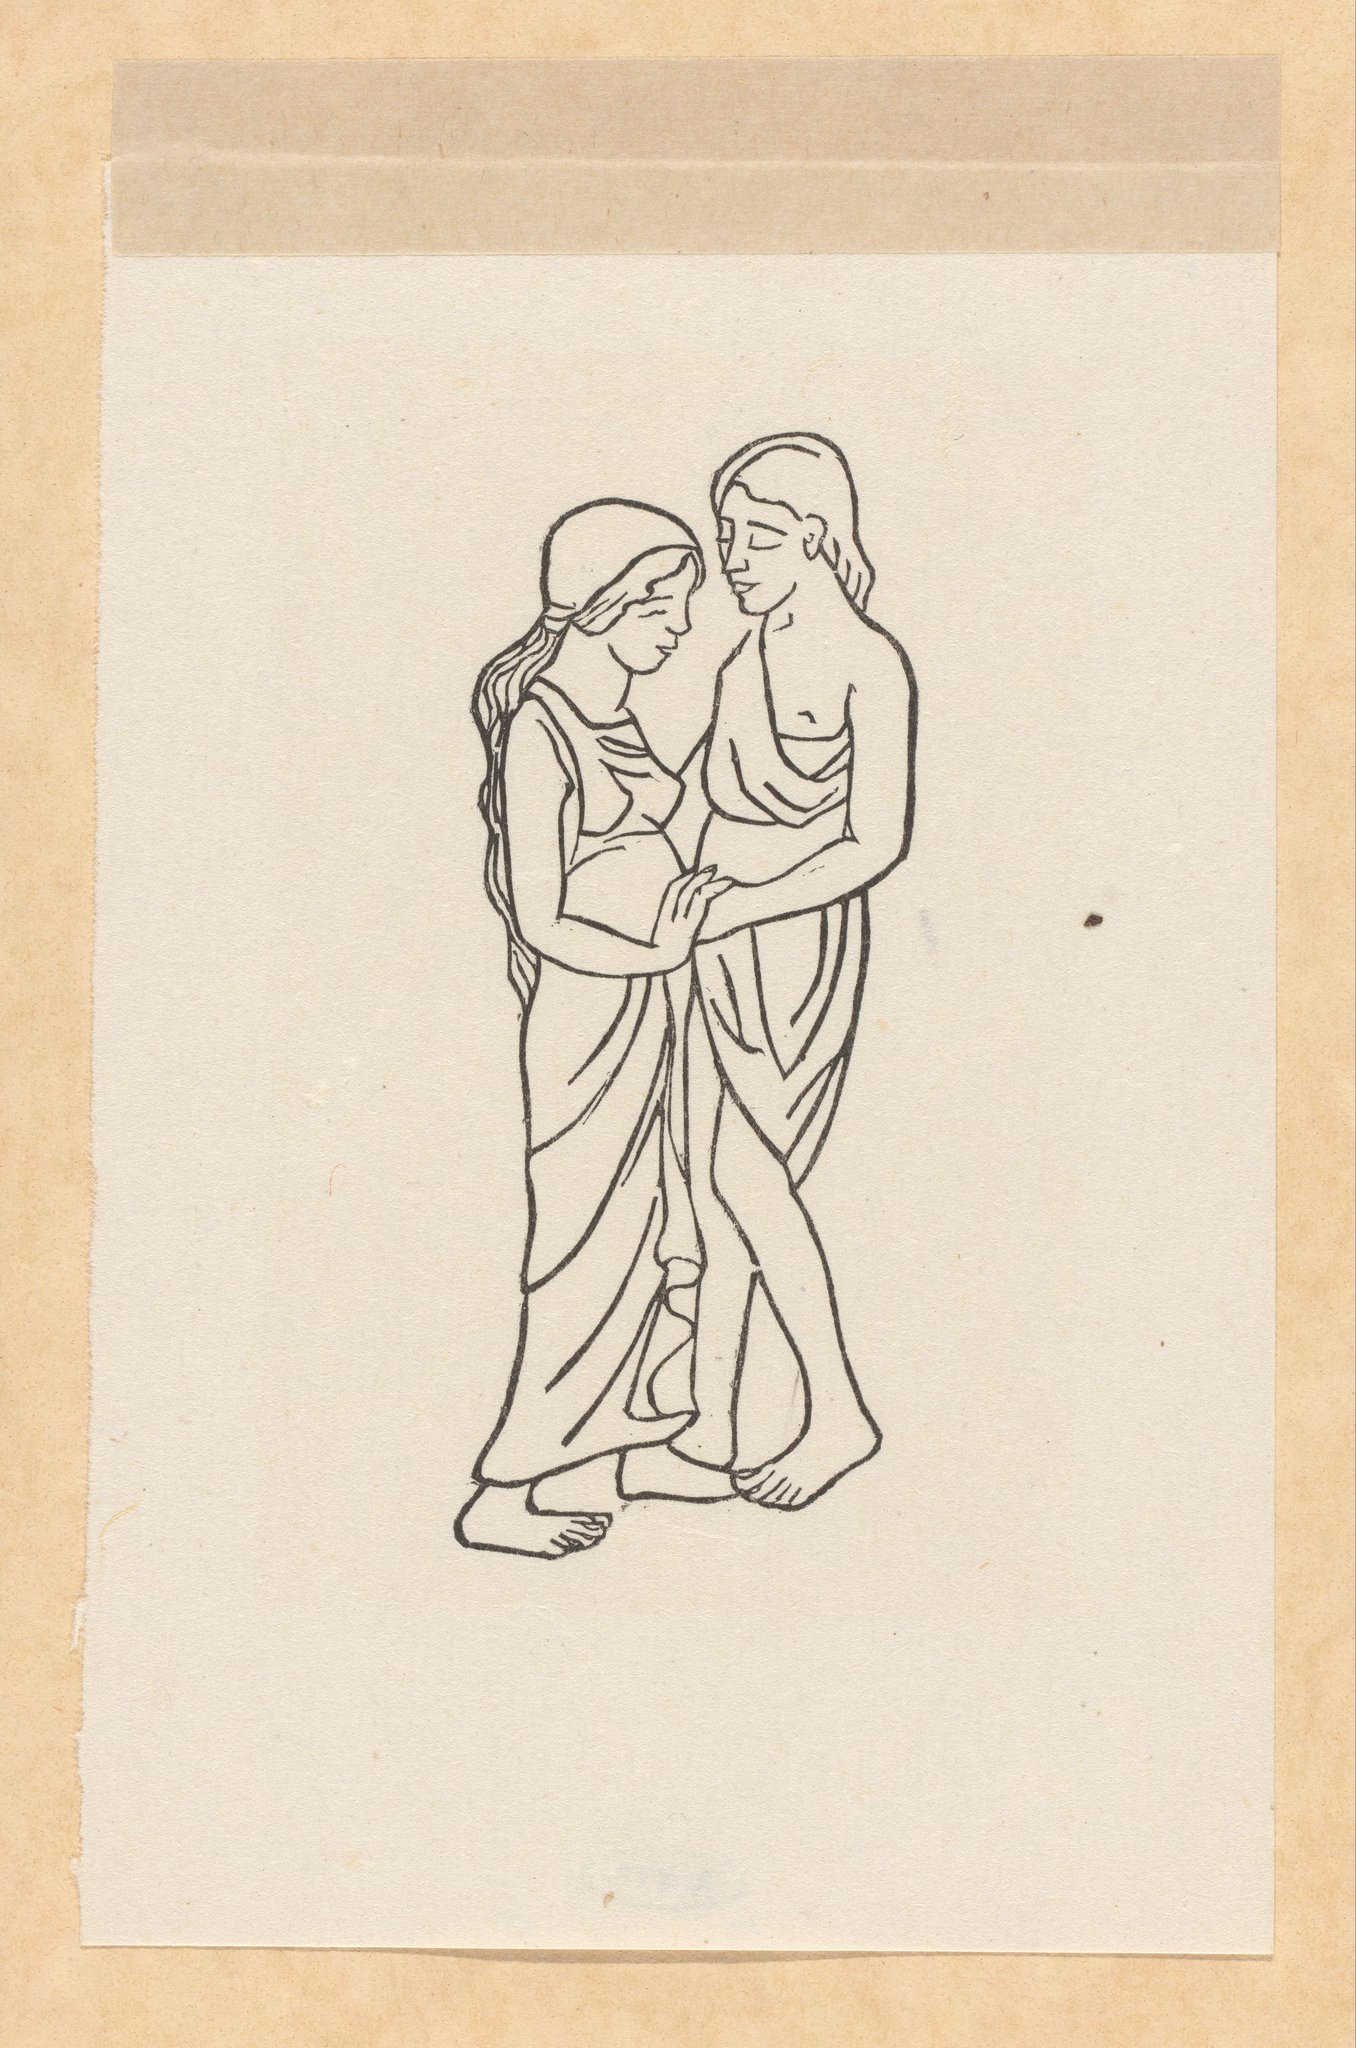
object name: book illustration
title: Daphnis en Chloë herenigd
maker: aristide maillol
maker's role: draughtsman, painter, print maker, sculptor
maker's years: 1861-1944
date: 1937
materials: paper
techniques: woodcut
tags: daphnis (in greek mythology a shepherd who invented pastoral poetry, chloe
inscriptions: collector's mark: Lugt 2228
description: Latere staat van deze prent gebruikt in: Longus. Les Pastorales de Longus ou Daphnis & Chloé. Parijs: Frères Gonin, 1935, p. 213.